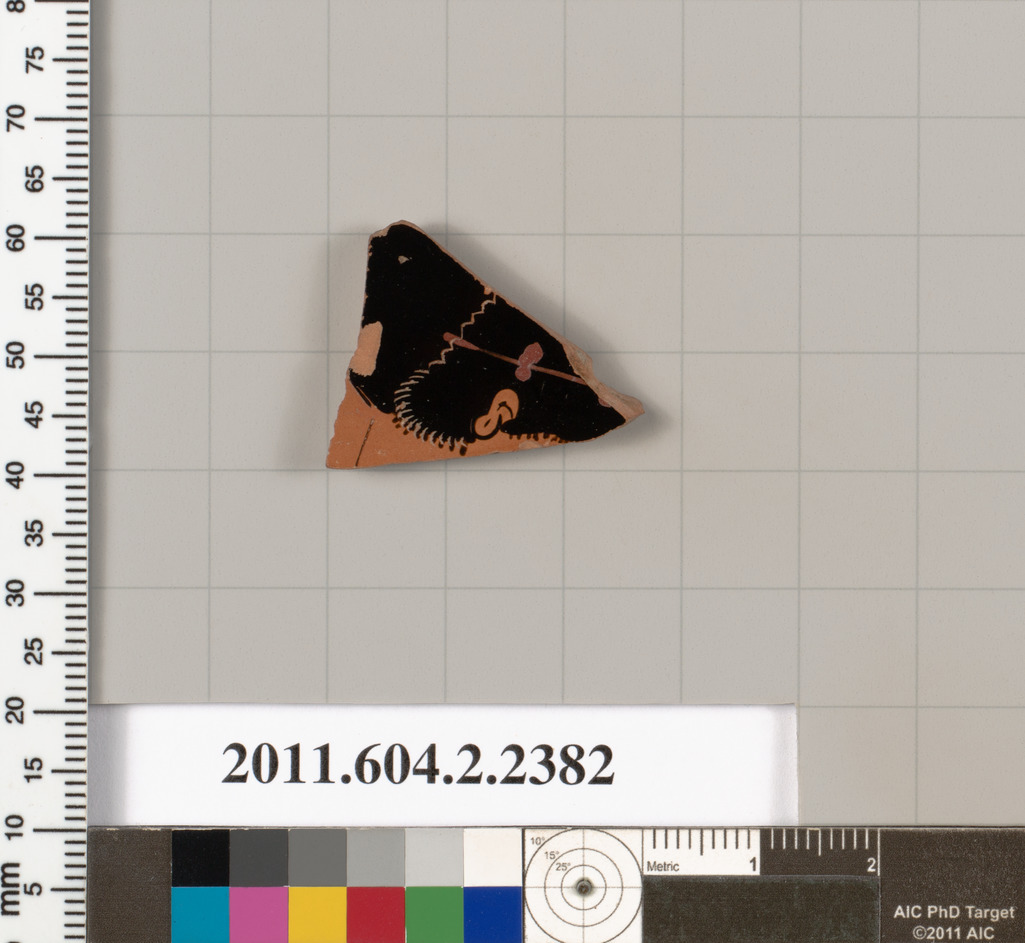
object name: pelike fragment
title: Terracotta fragment of a pelike (jar)?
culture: greek, attic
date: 520-510 BCE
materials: terracotta